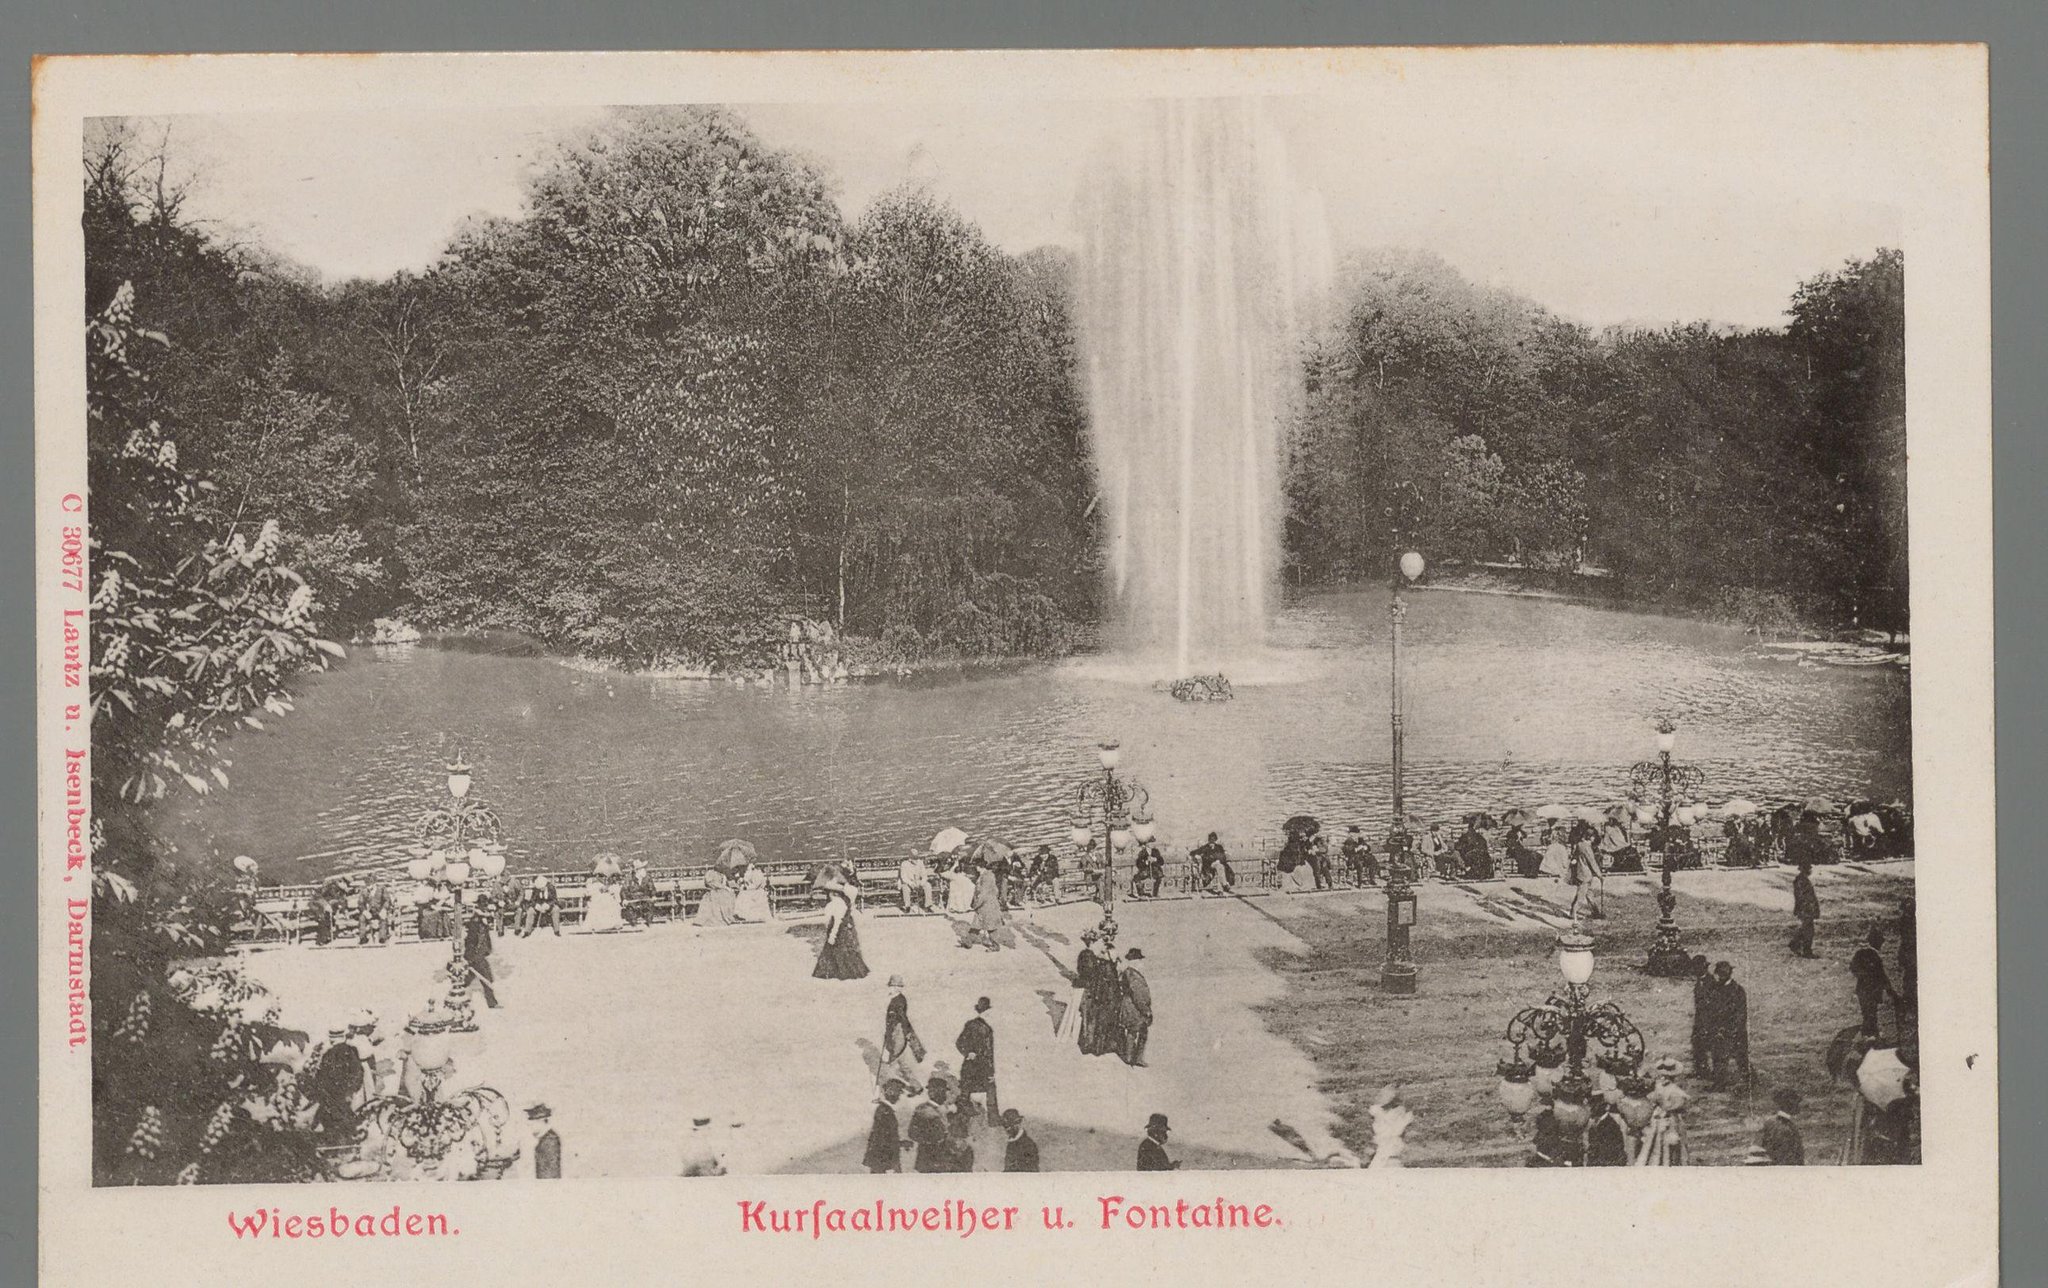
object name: ansichtkaart, prentbriefkaart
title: Wiesbaden. Kursaalmeiher u. Fontaine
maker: Anonymous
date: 1885-1905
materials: cardboard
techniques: photograph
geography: darmstadt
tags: garden fountain, watering-place, spa